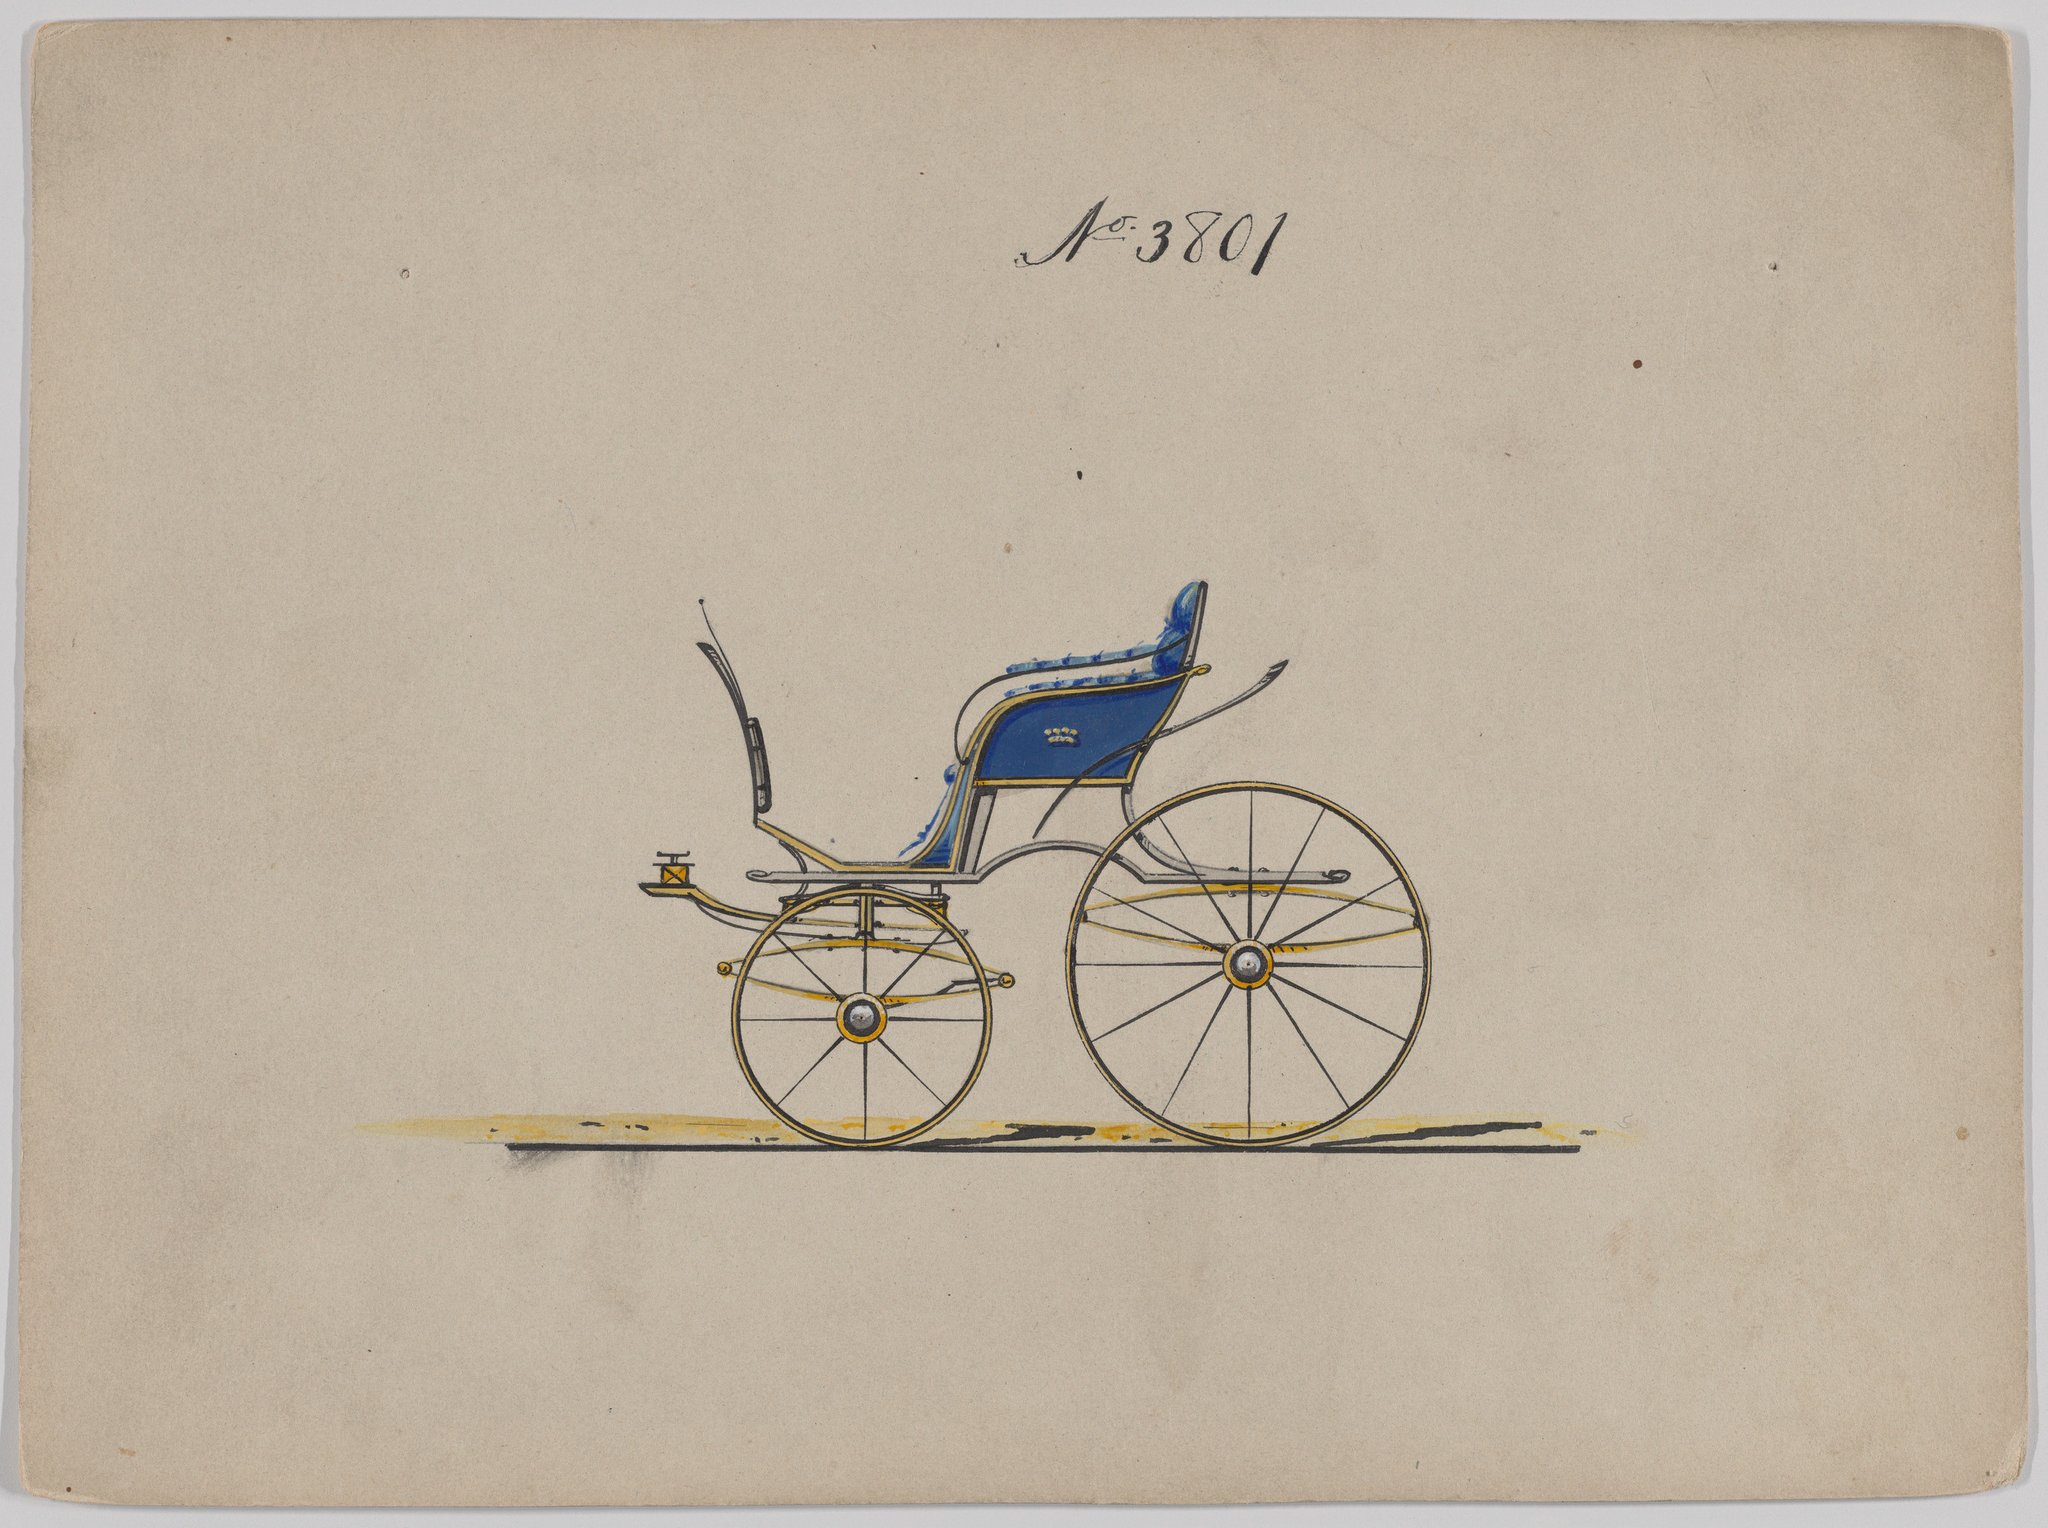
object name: drawing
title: Design for Pony Phaeton, no. 3801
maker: brewster & co.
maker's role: manufacturer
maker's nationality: american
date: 1883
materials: gouache, gum arabic, ink, watercolor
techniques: pen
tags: carriages